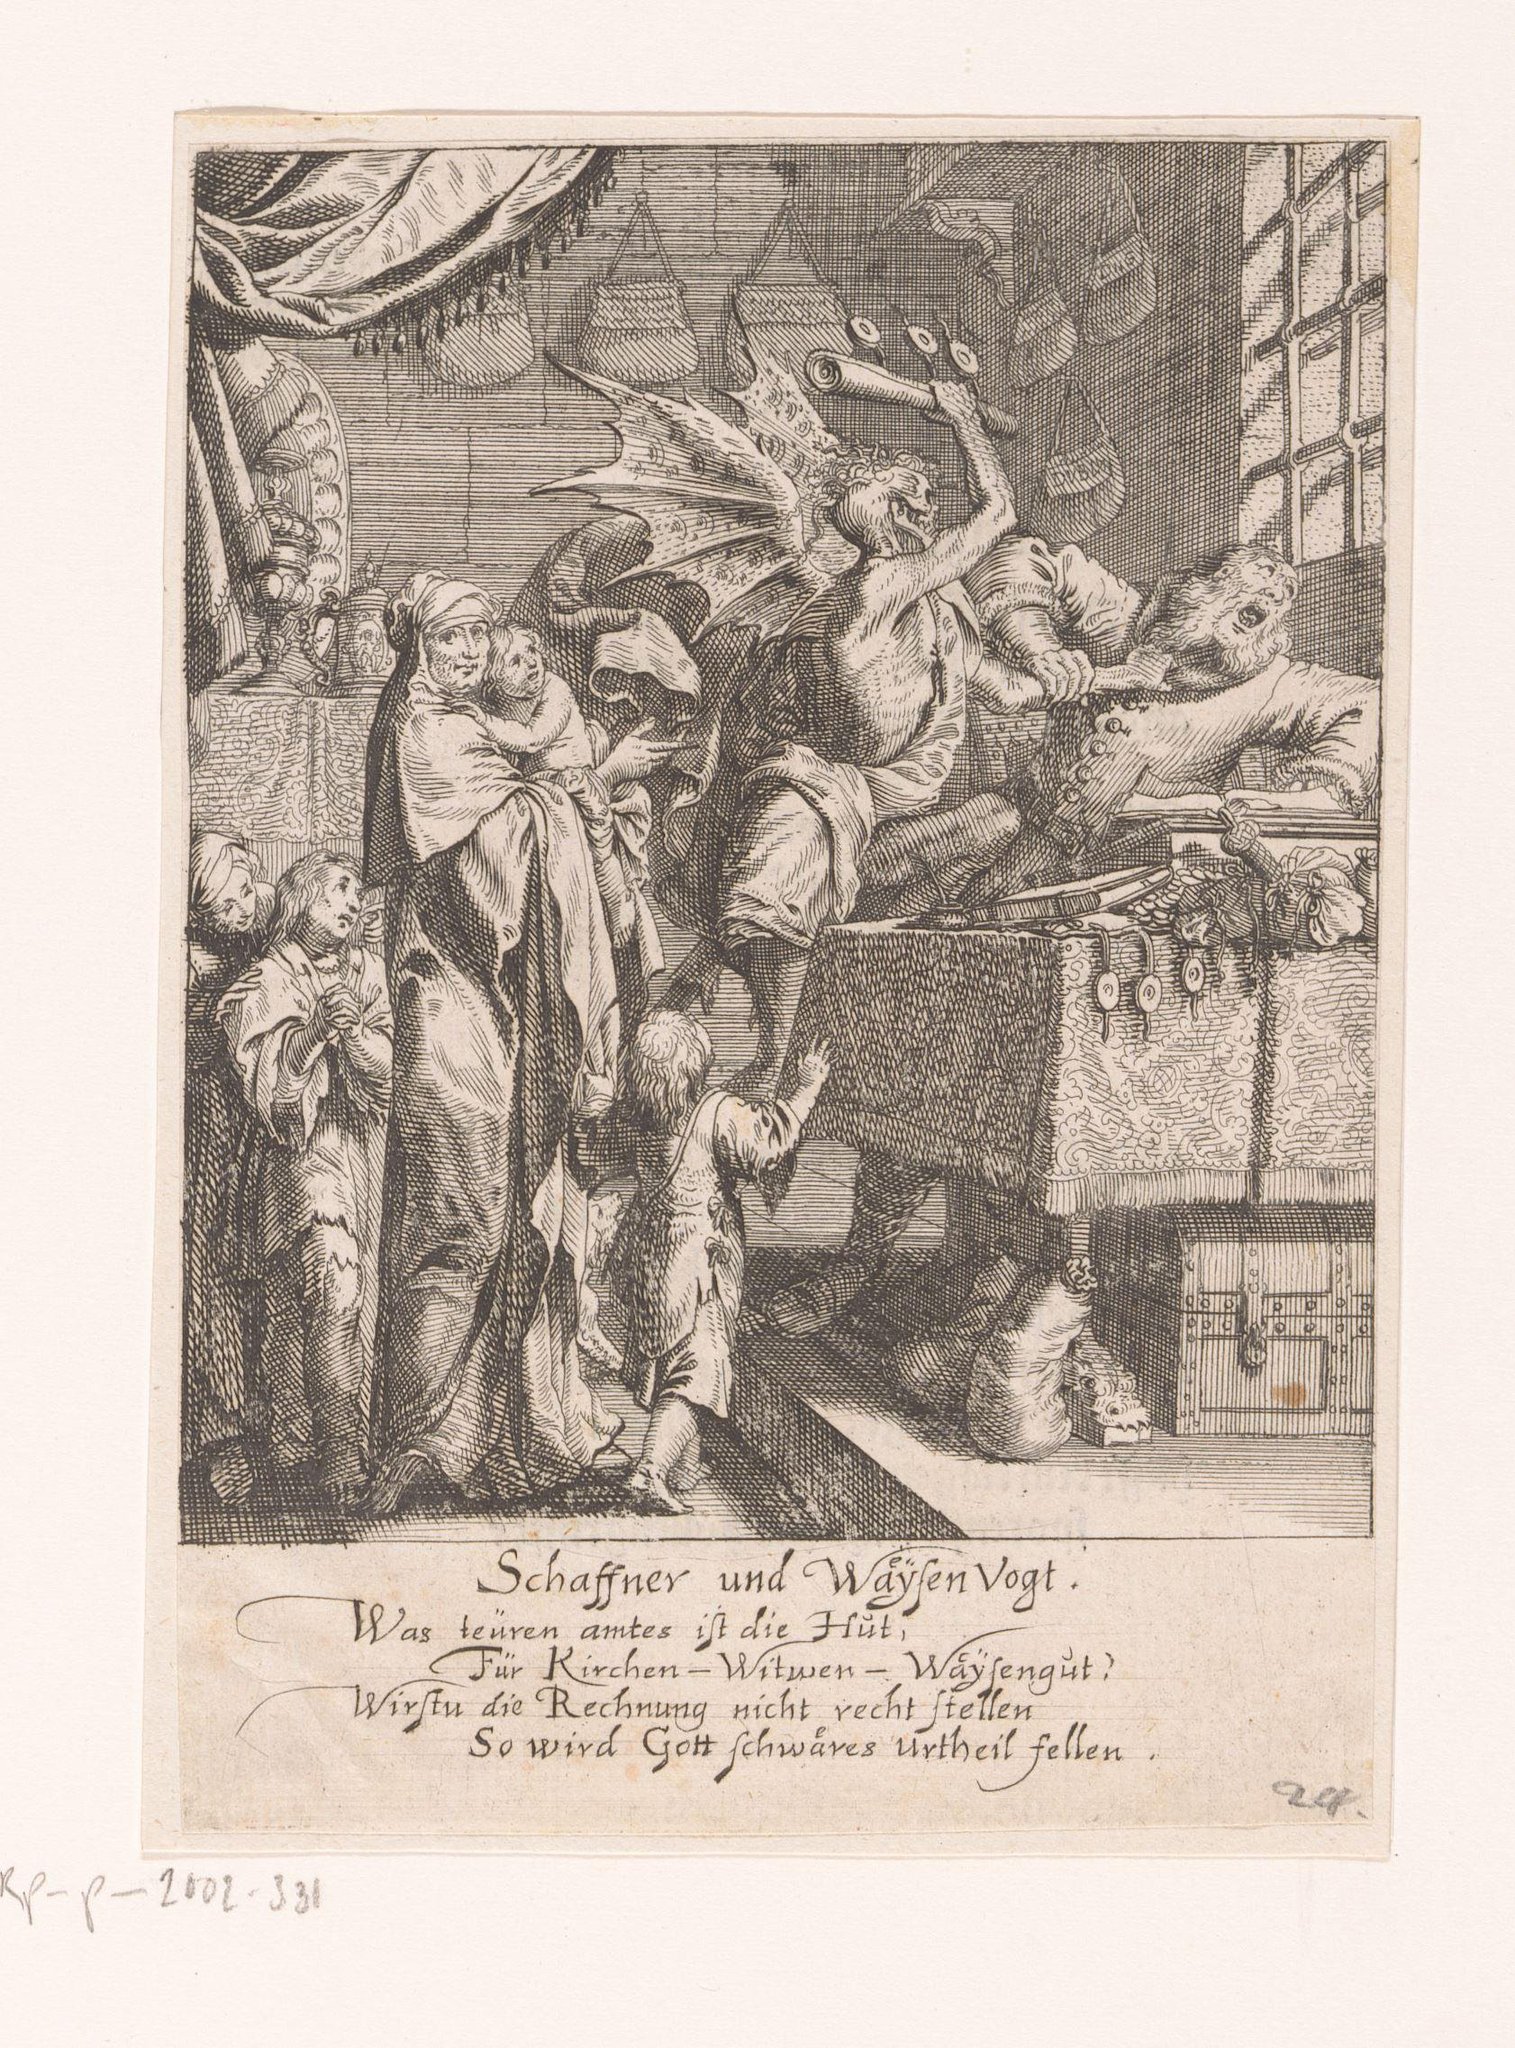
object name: book illustration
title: Geldlener en deurwaarder met de Dood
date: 1650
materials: paper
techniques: etching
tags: personifications of death; 'morte' (ripa), dance of death; death together with one or more human beings, law and jurisprudence (+ judge)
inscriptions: collector's mark: Lugt 2228, collector's mark: Lugt 2233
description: Prent uit: Meyer, Rudolph. Sterbenspiegel, das ist sonnenklare Vorstellung menschlicher Nichtigkeit durch alle Ständ und Geschlechter (...). Zürich: J.J. Bodmer, 1650.